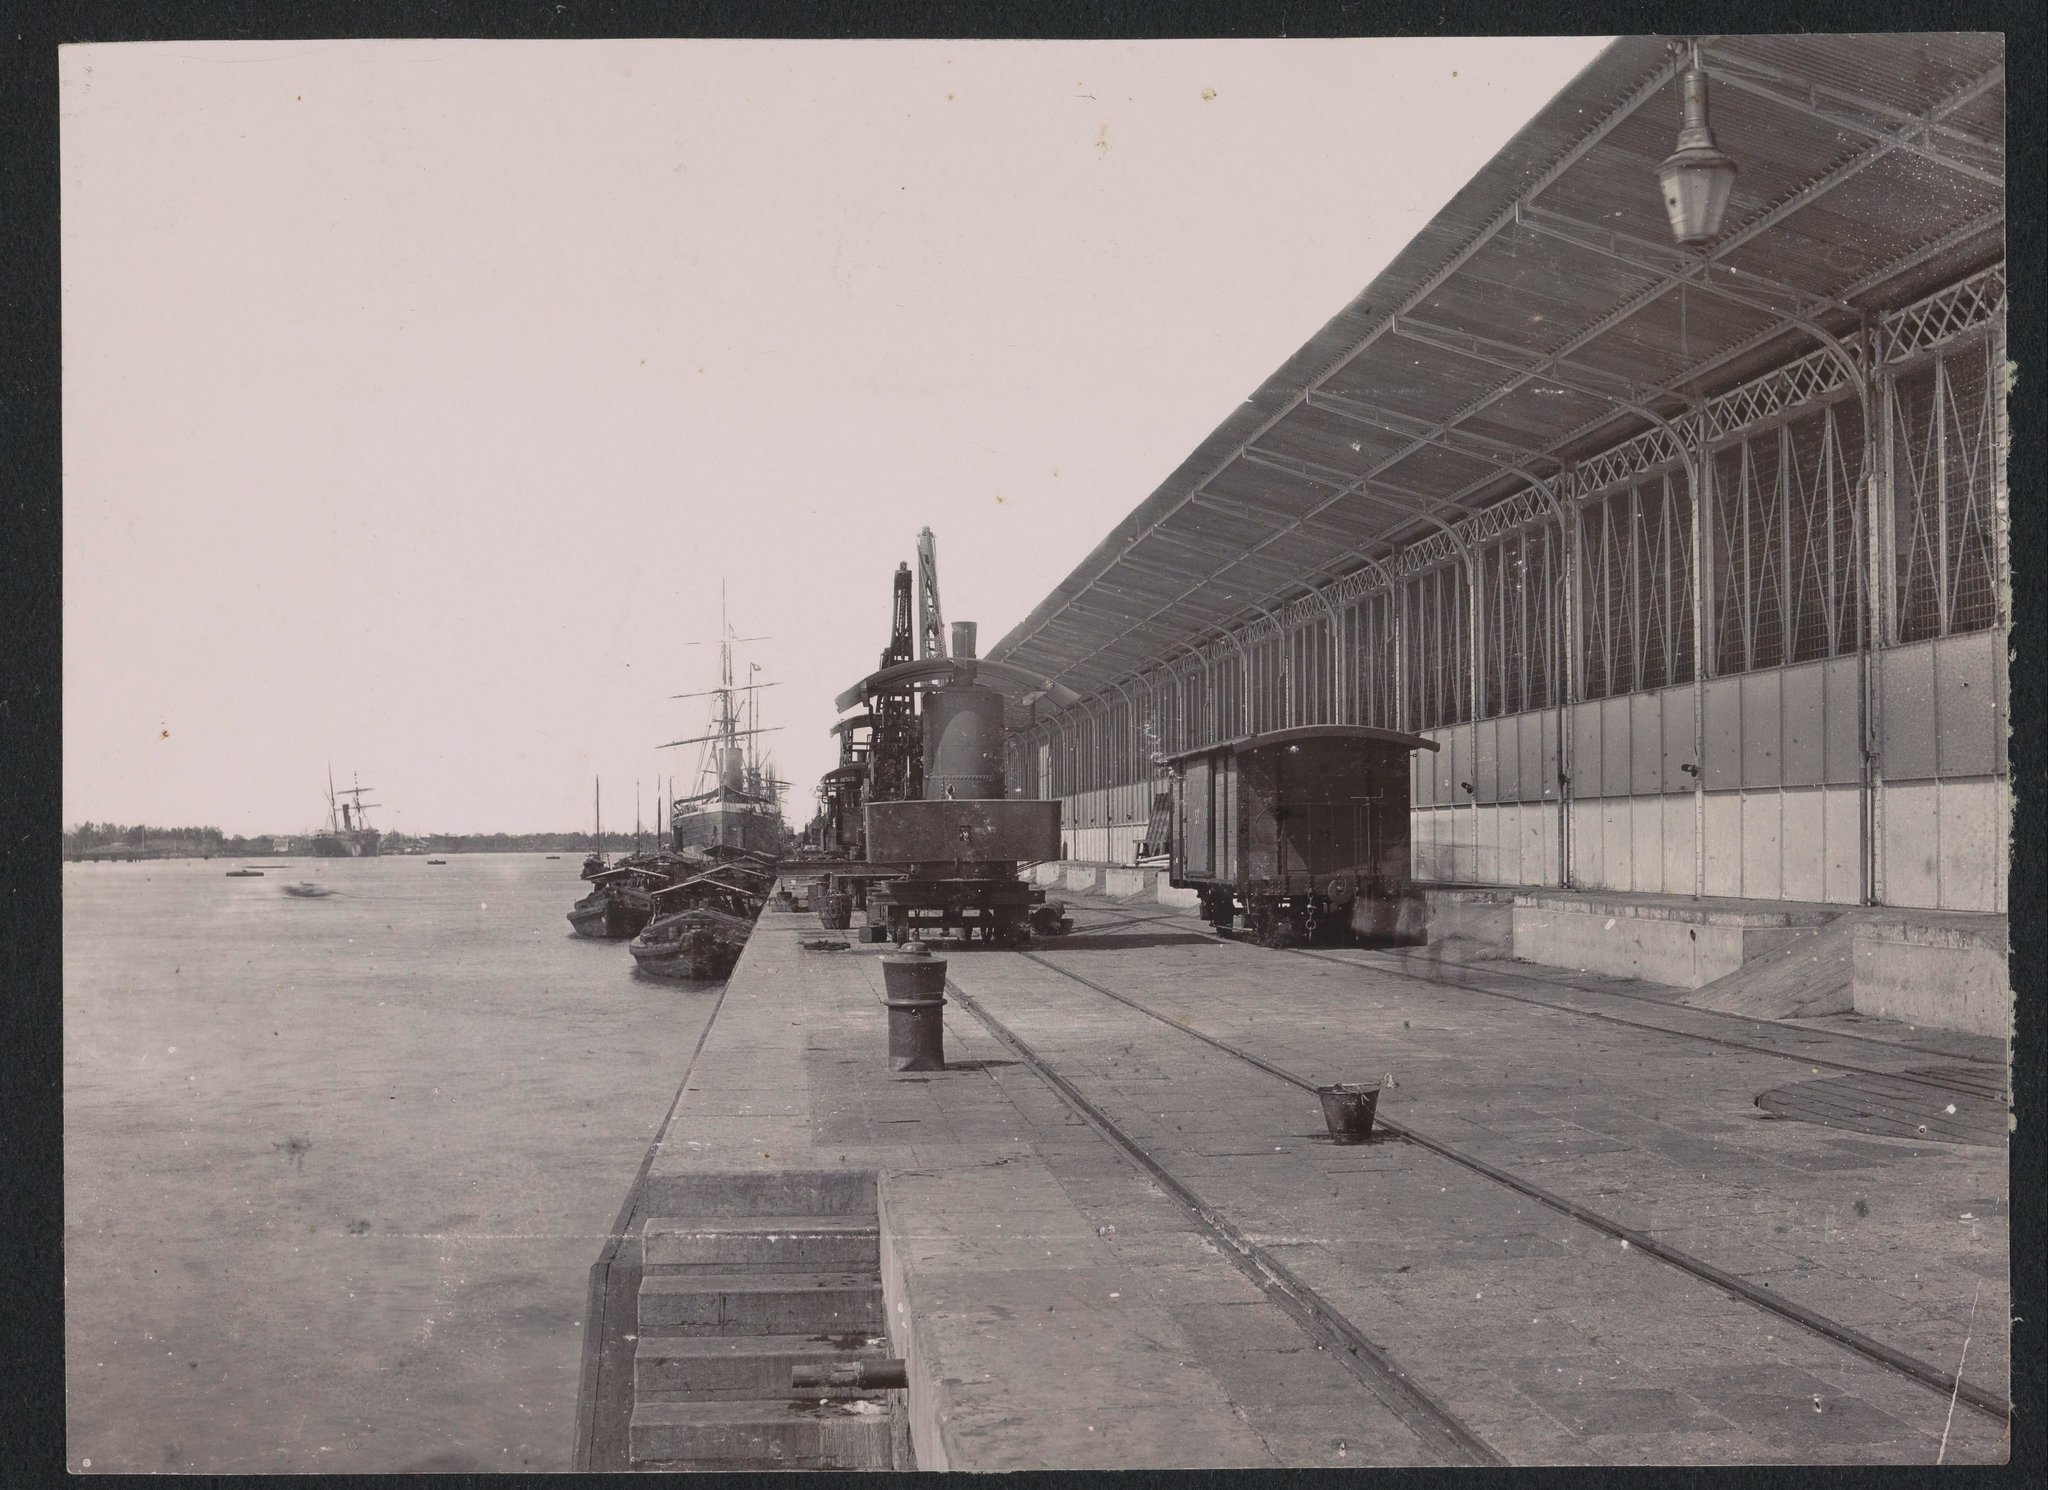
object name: photograph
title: Goederenstation aan een haven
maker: Anonymous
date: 1900-1930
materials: paper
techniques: collodion silver print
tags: harbour